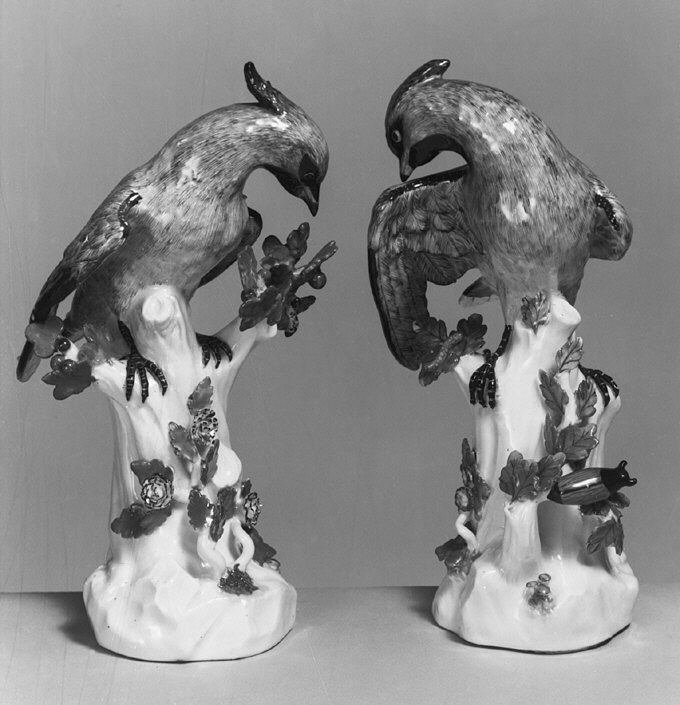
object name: figure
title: Waxwing (one of a pair)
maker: meissen manufactory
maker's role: manufactory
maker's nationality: german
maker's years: 1710-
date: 1741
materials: hard paste porcelain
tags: birds